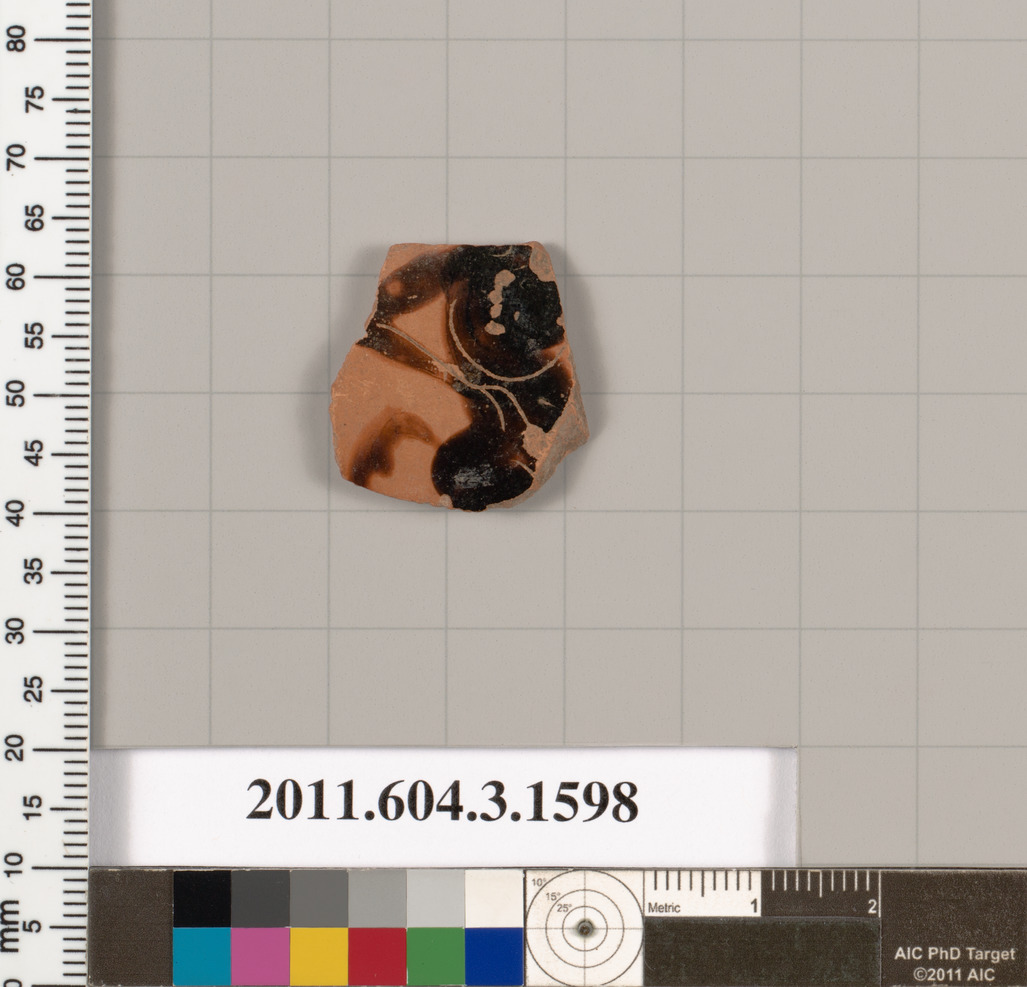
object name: kylix fragment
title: Terracotta fragment of a kylix: Band cup (drinking cup)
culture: greek, attic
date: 550-526 BCE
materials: terracotta